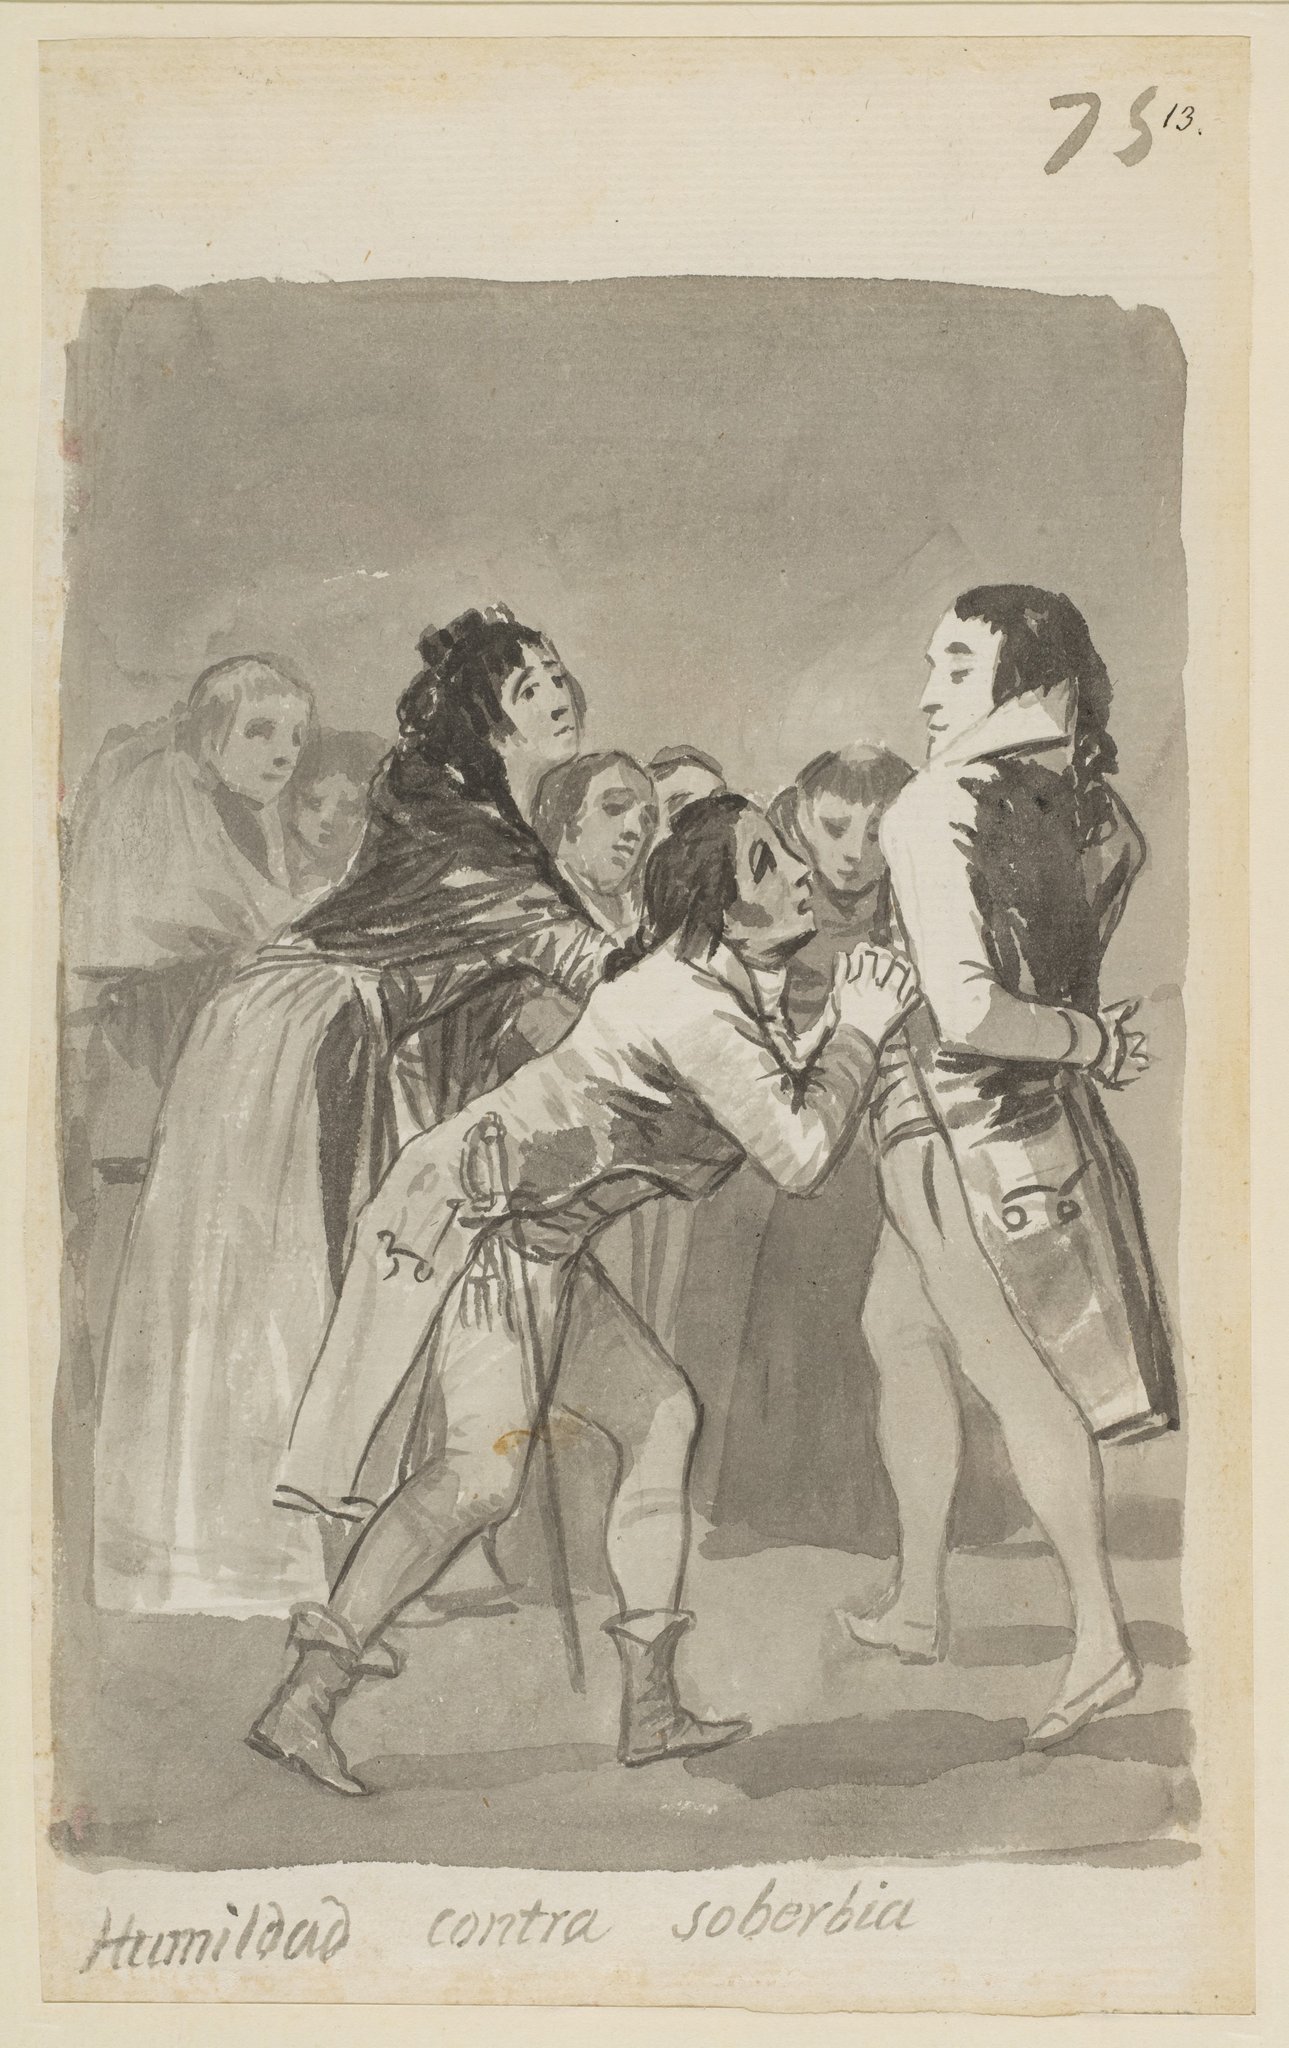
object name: drawing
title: Humility versus Pride; a young man imploring an older man with other figures in front of them; folio 75 (recto) from the Madrid Album "B"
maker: goya (francisco de goya y lucientes)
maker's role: artist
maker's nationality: spanish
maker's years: 1746-1828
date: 1796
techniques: brush, wash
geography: spain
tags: men,women